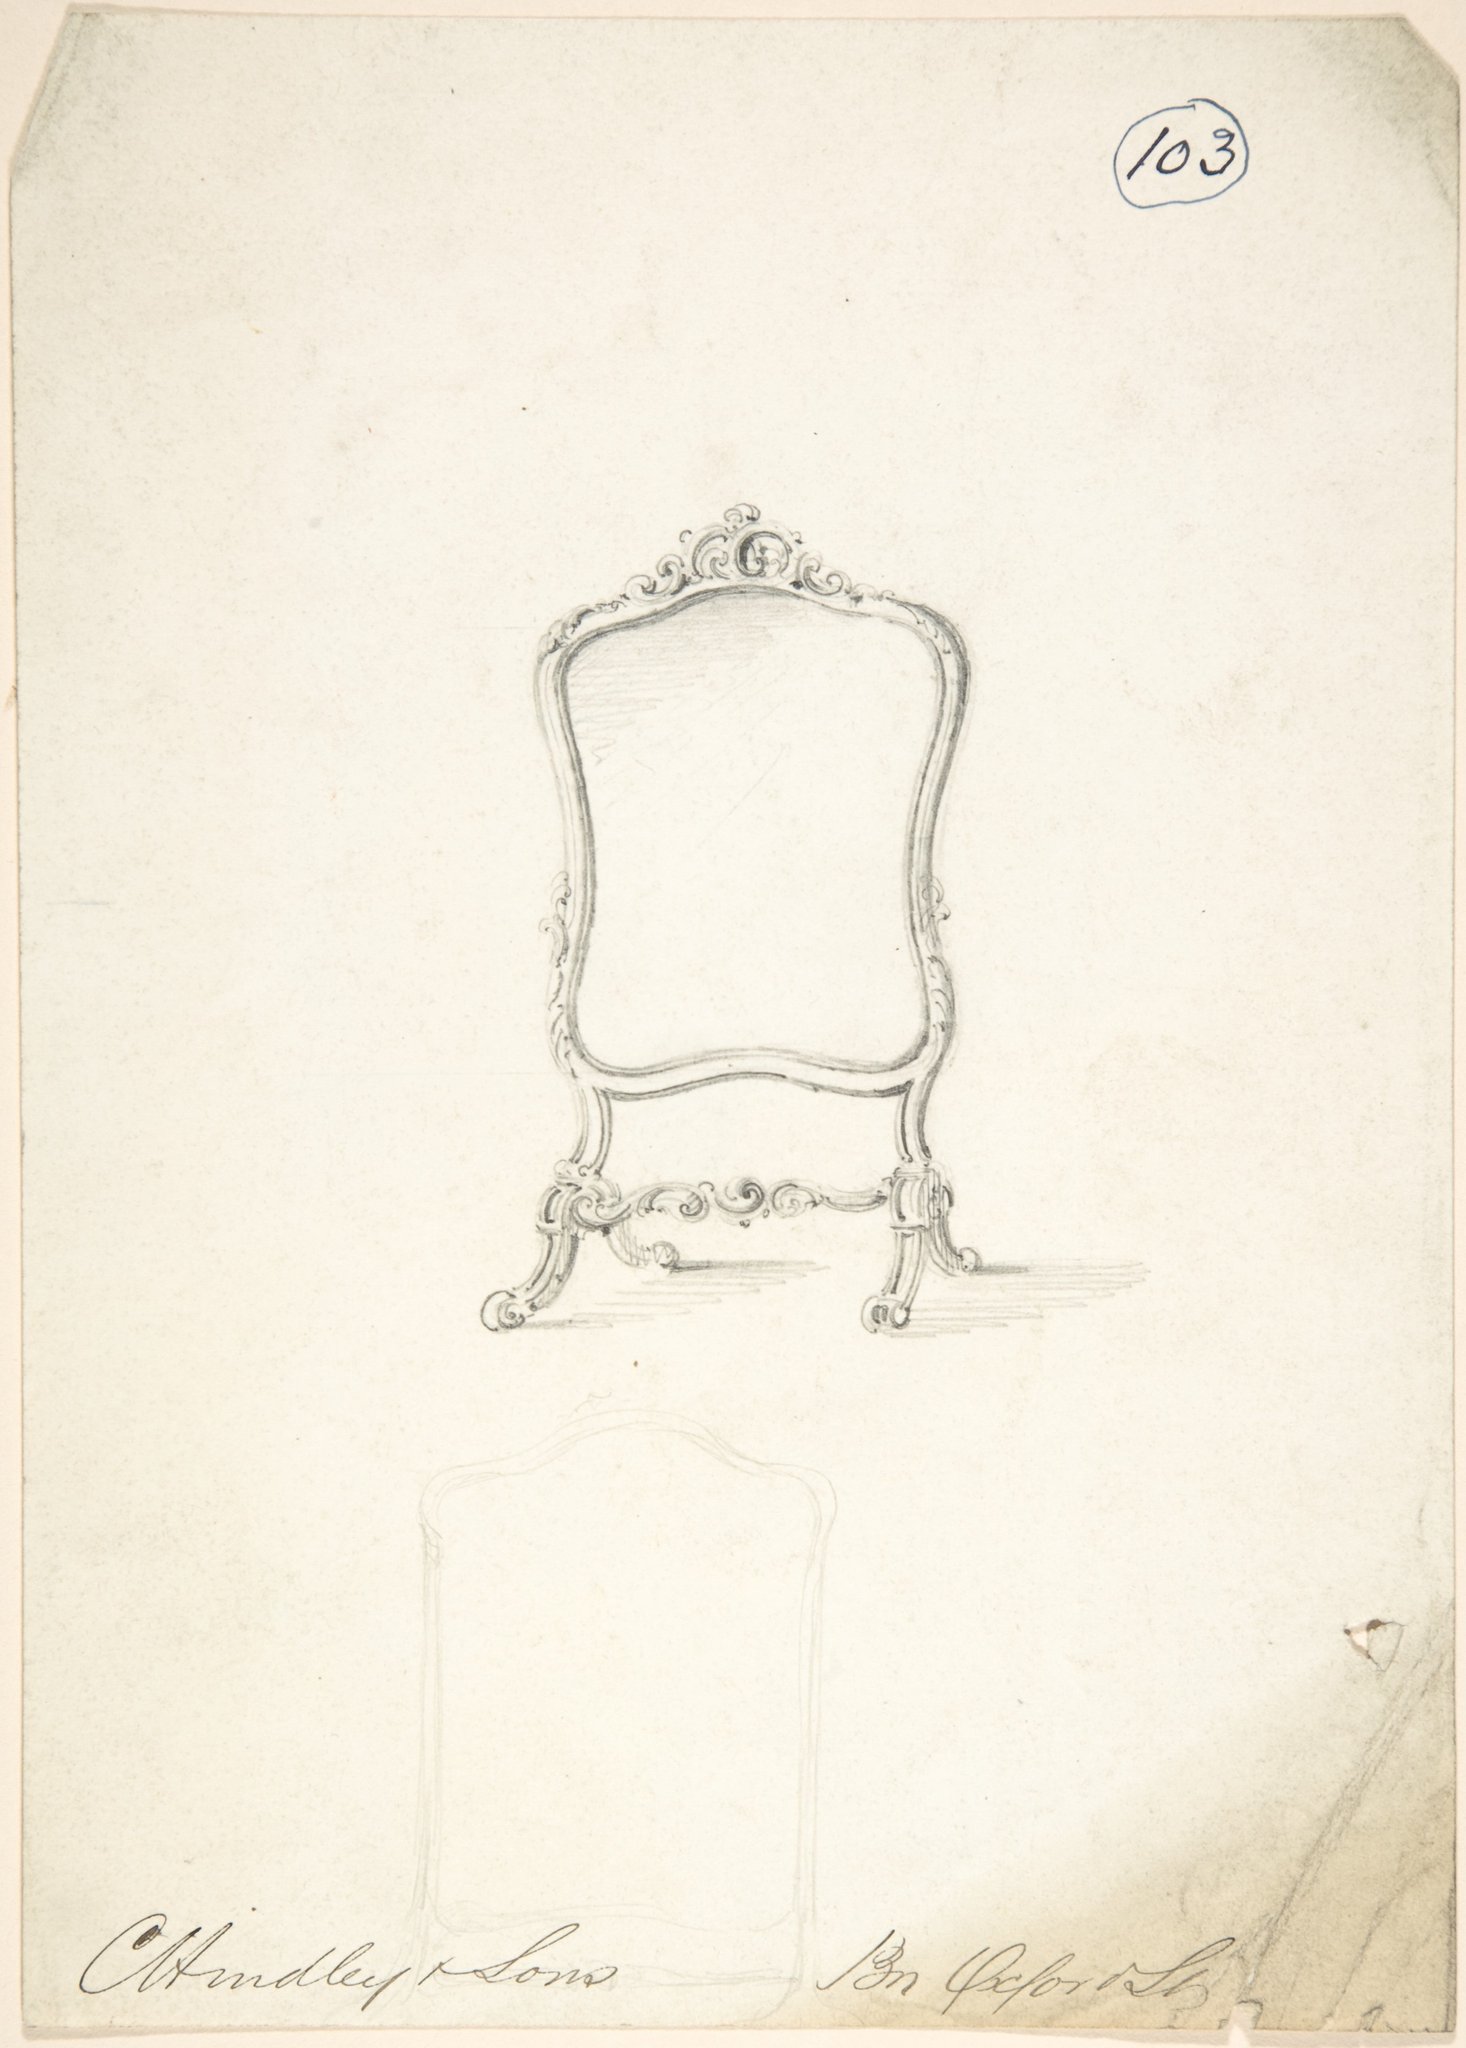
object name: drawing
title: Design for a Standing Frame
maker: charles hindley and sons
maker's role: artist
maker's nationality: british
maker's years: 1841-1917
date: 1841-1884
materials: graphite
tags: furniture